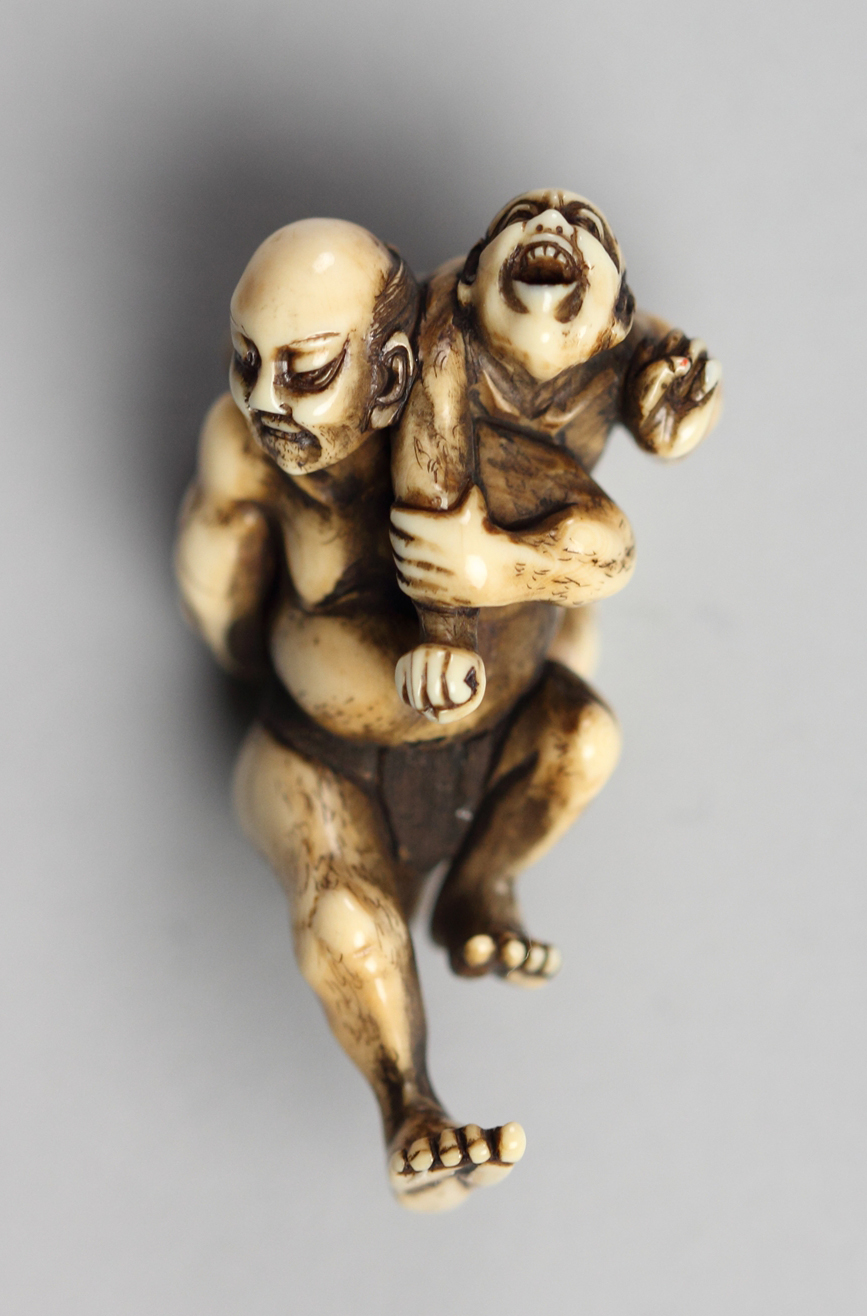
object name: netsuke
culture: japanese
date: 1801-1900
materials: ivory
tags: men